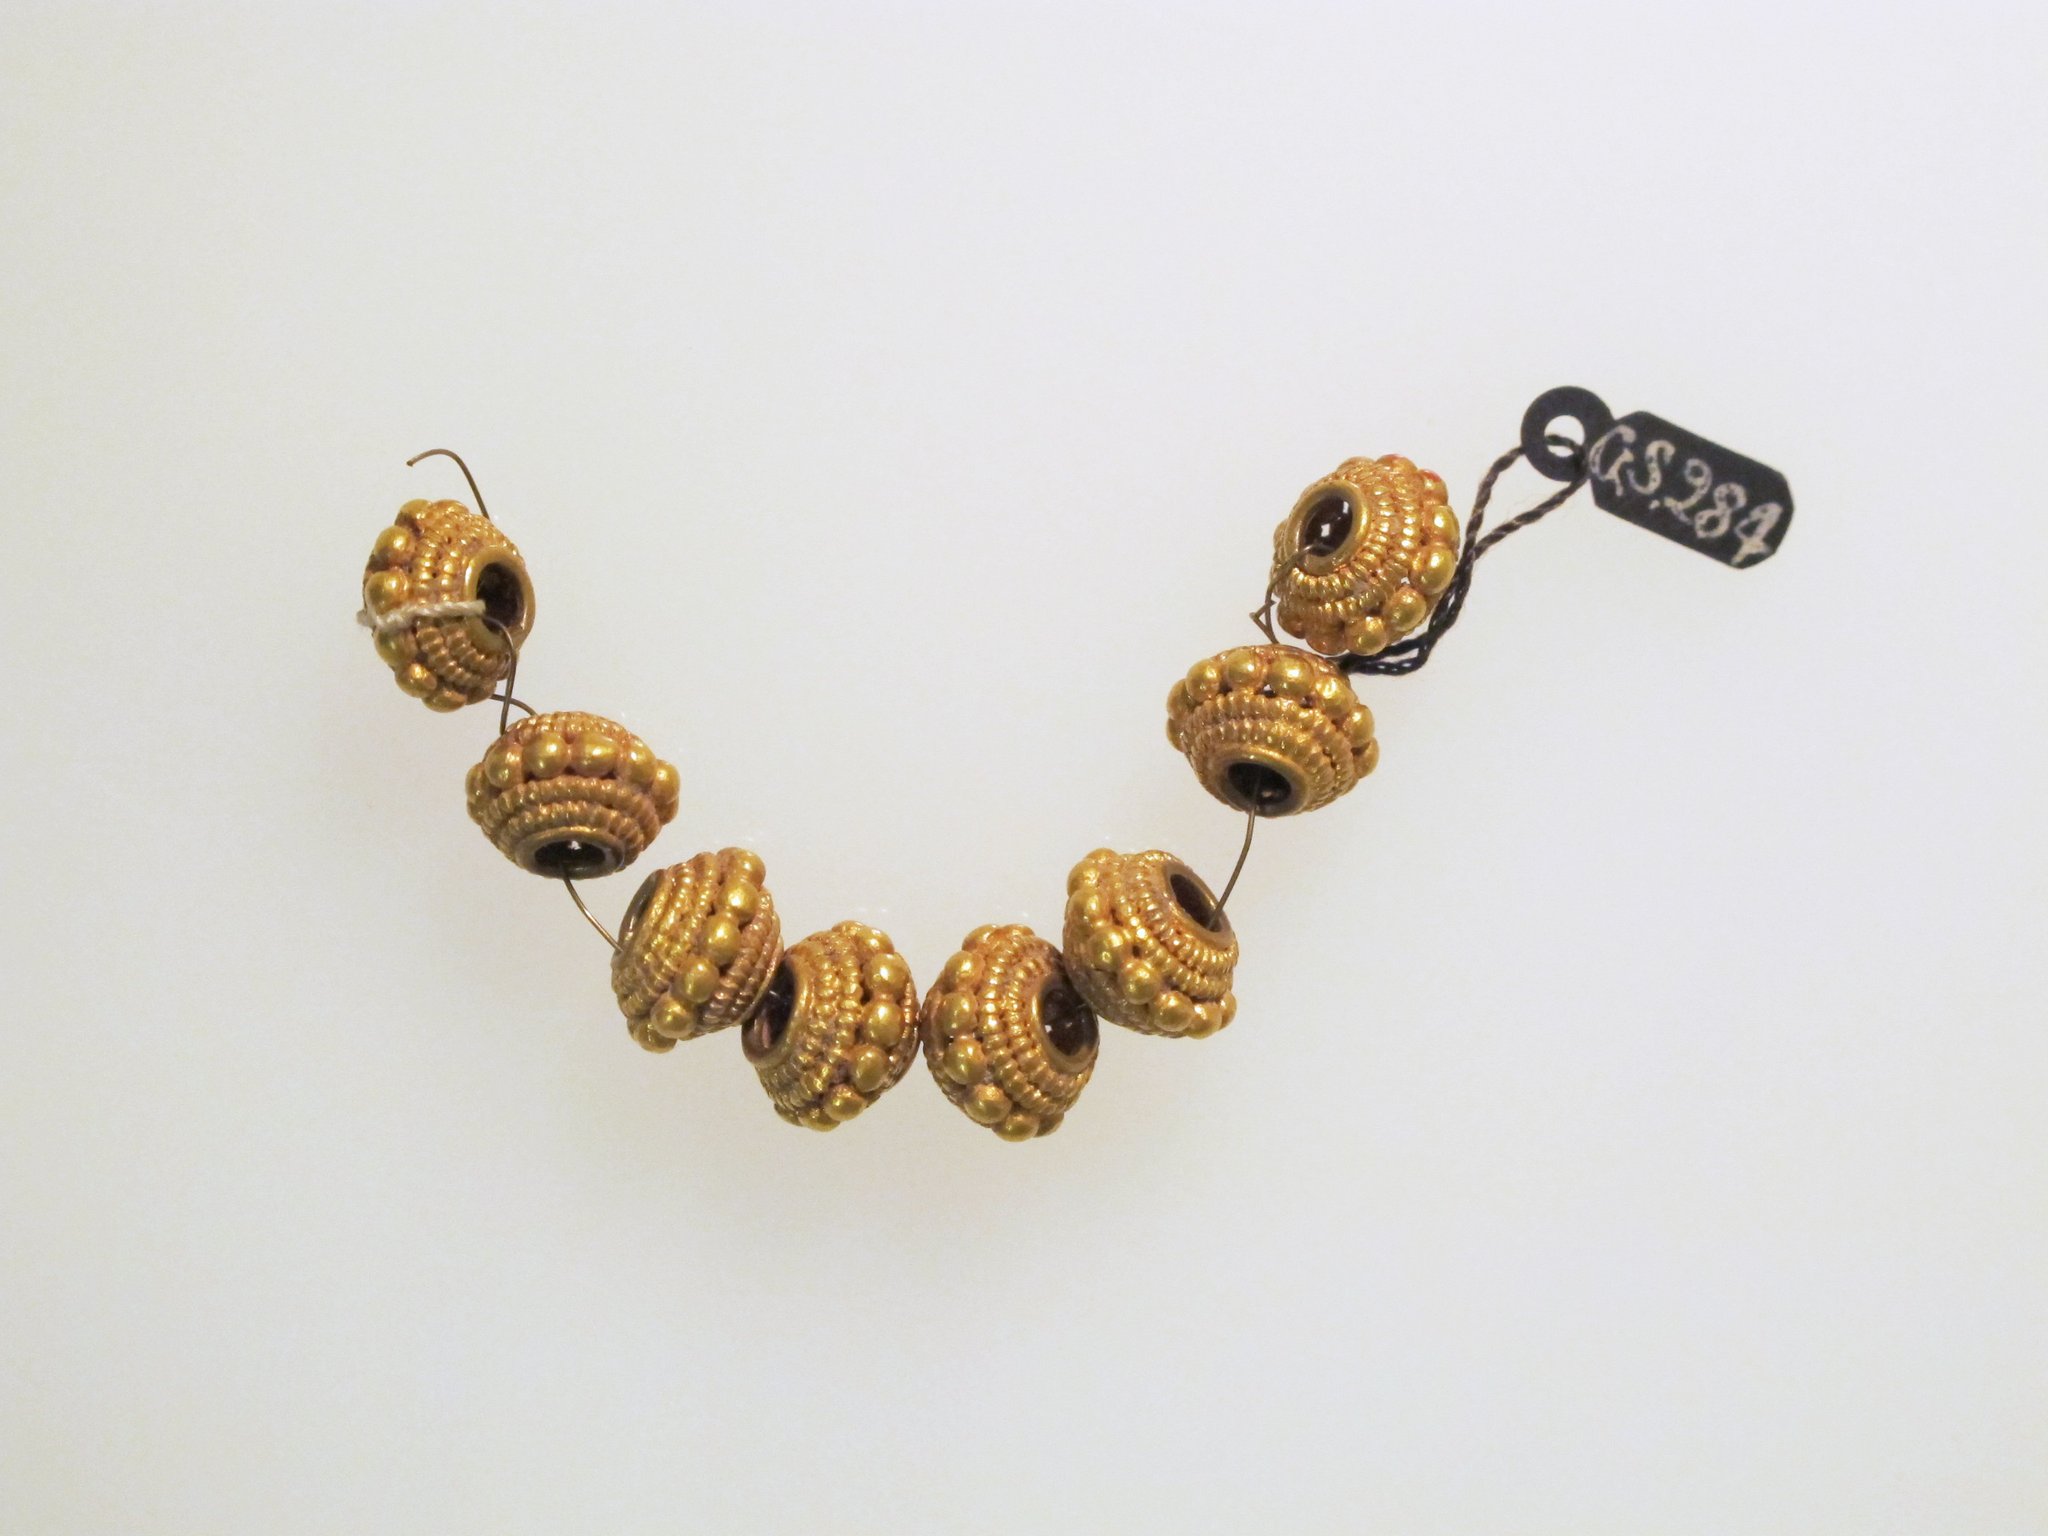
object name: necklace fragment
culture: greek or roman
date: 1-100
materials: gold